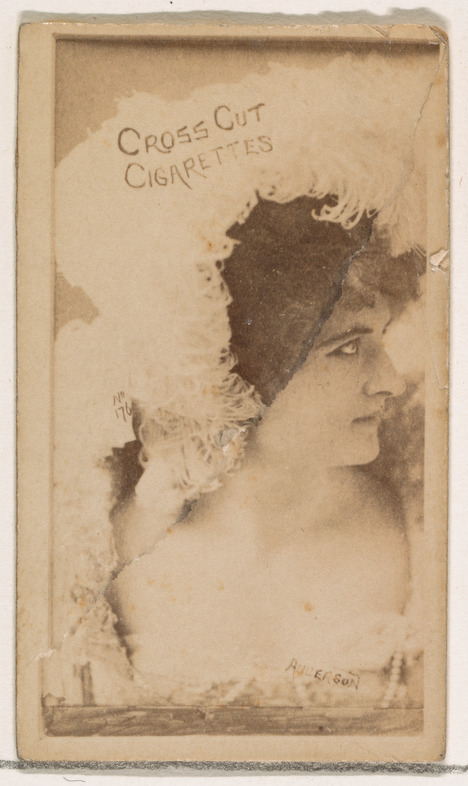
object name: print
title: Anderson, from the Actors and Actresses series (N145-1) issued by Duke Sons & Co. to promote Cross Cut Cigarettes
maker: w. duke, sons & co.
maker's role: publisher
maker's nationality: american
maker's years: 1870-1920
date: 1880-1889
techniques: albumen silver print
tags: women,actresses